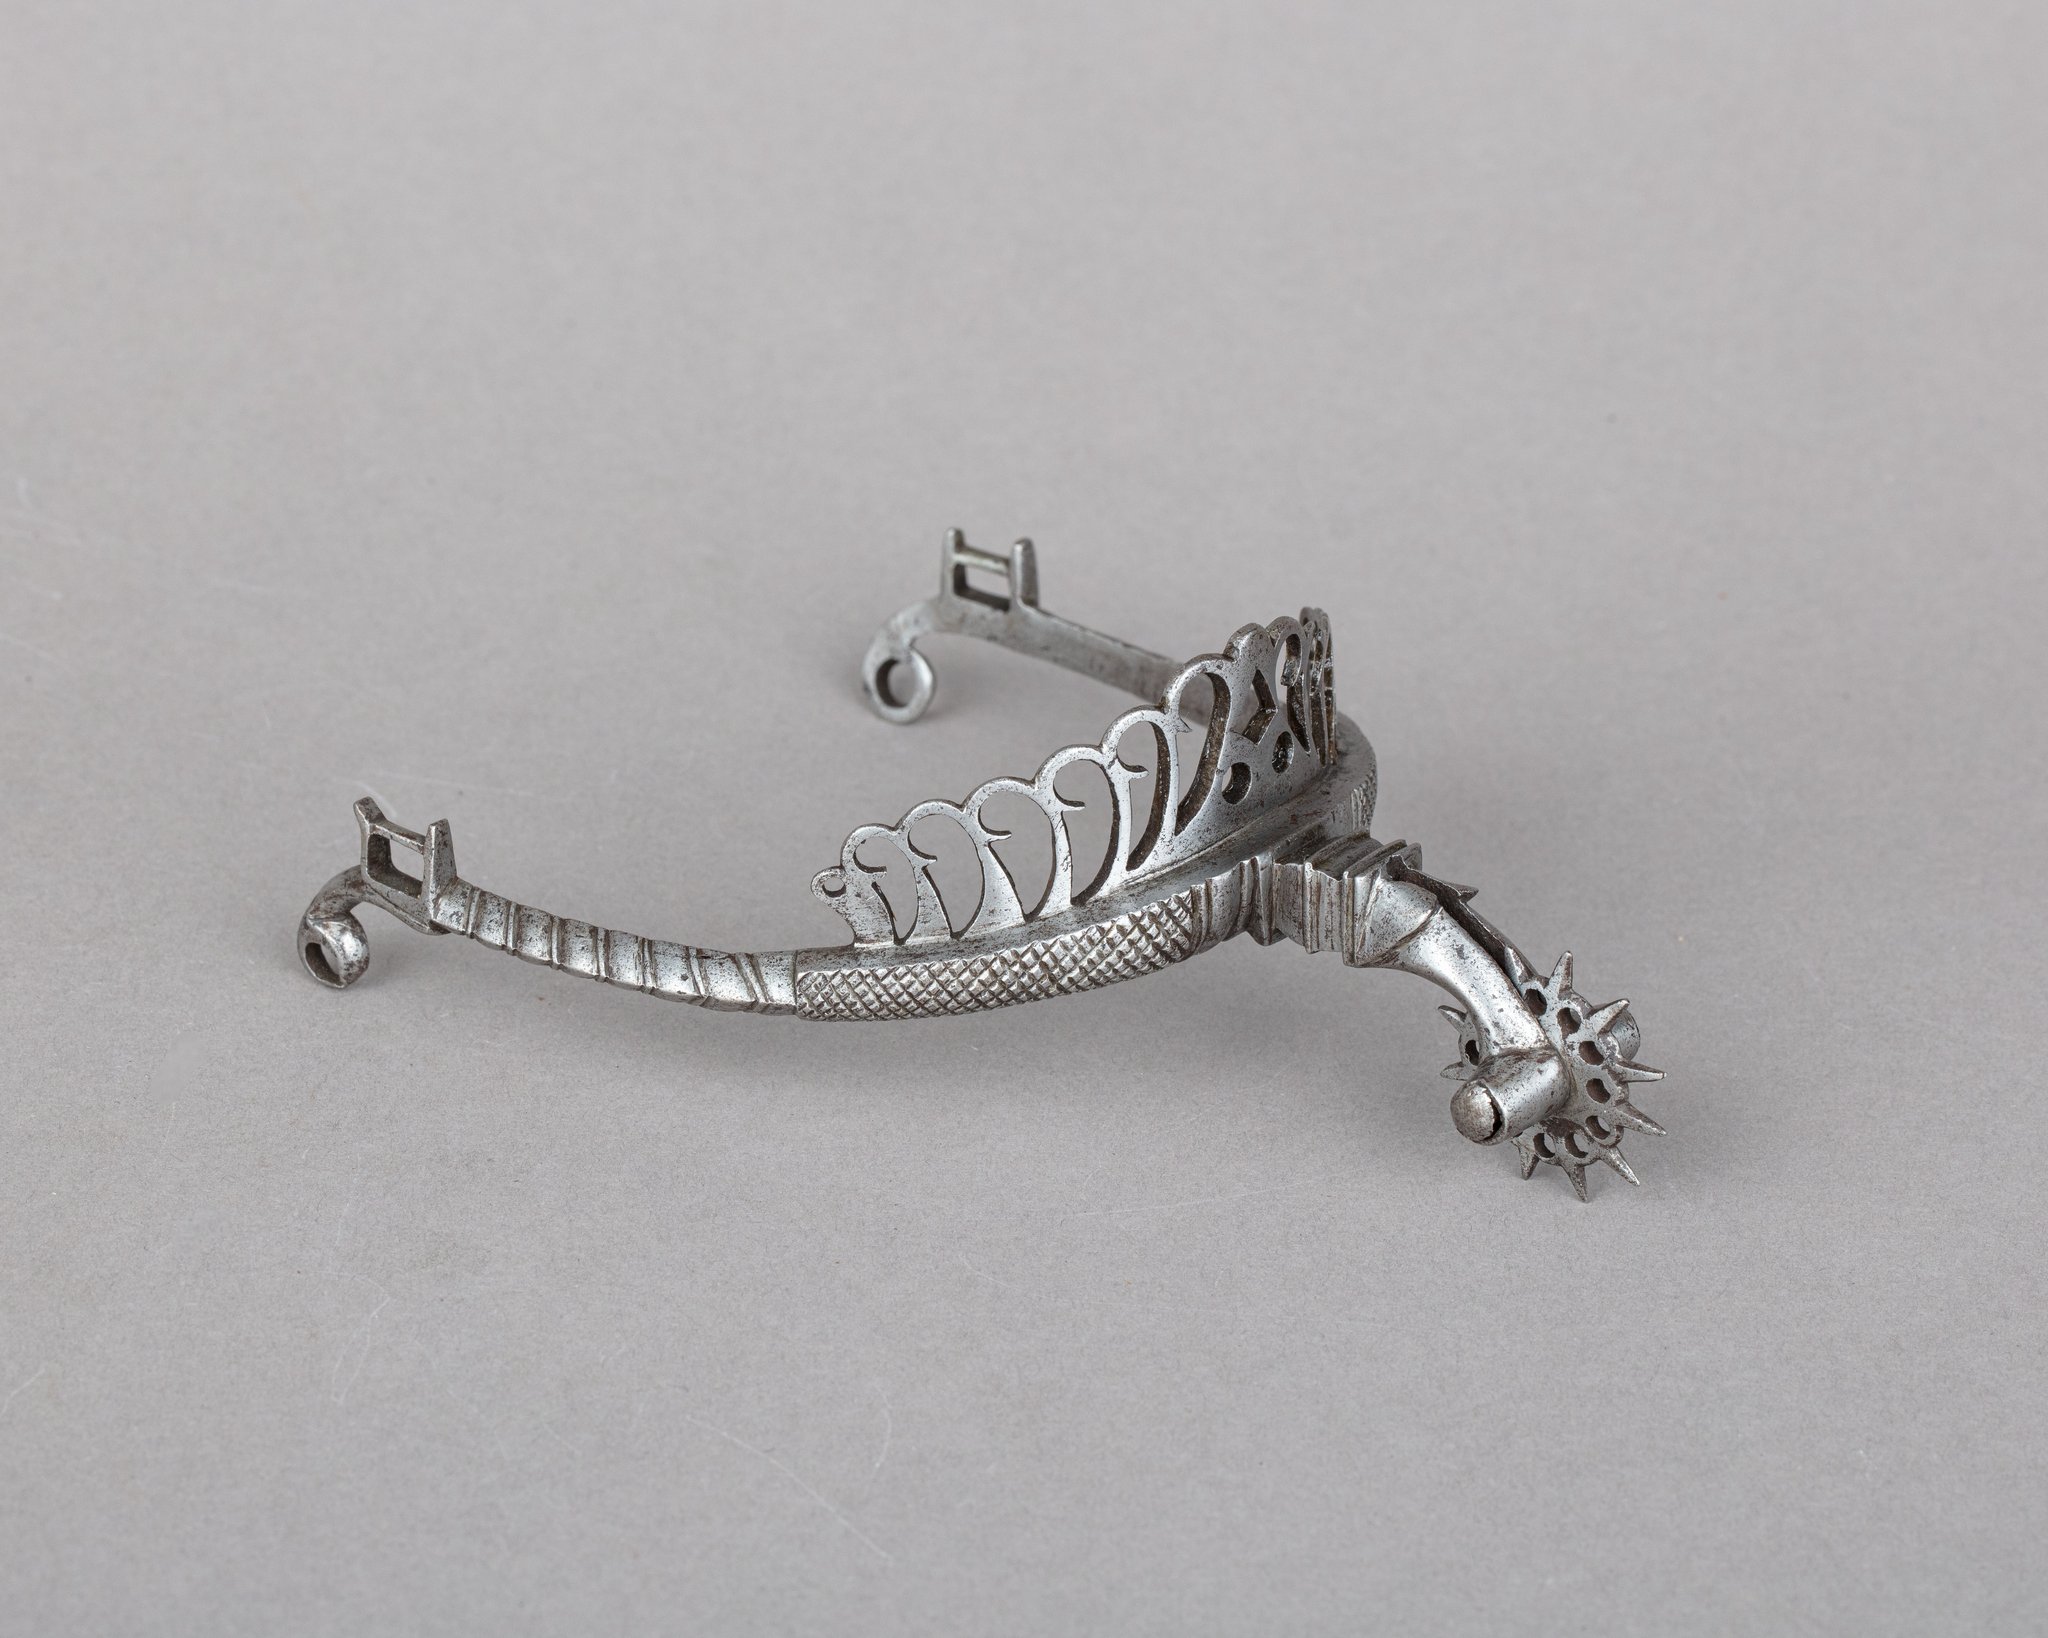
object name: spur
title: Rowel Spur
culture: german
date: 1600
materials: metal alloy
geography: germany